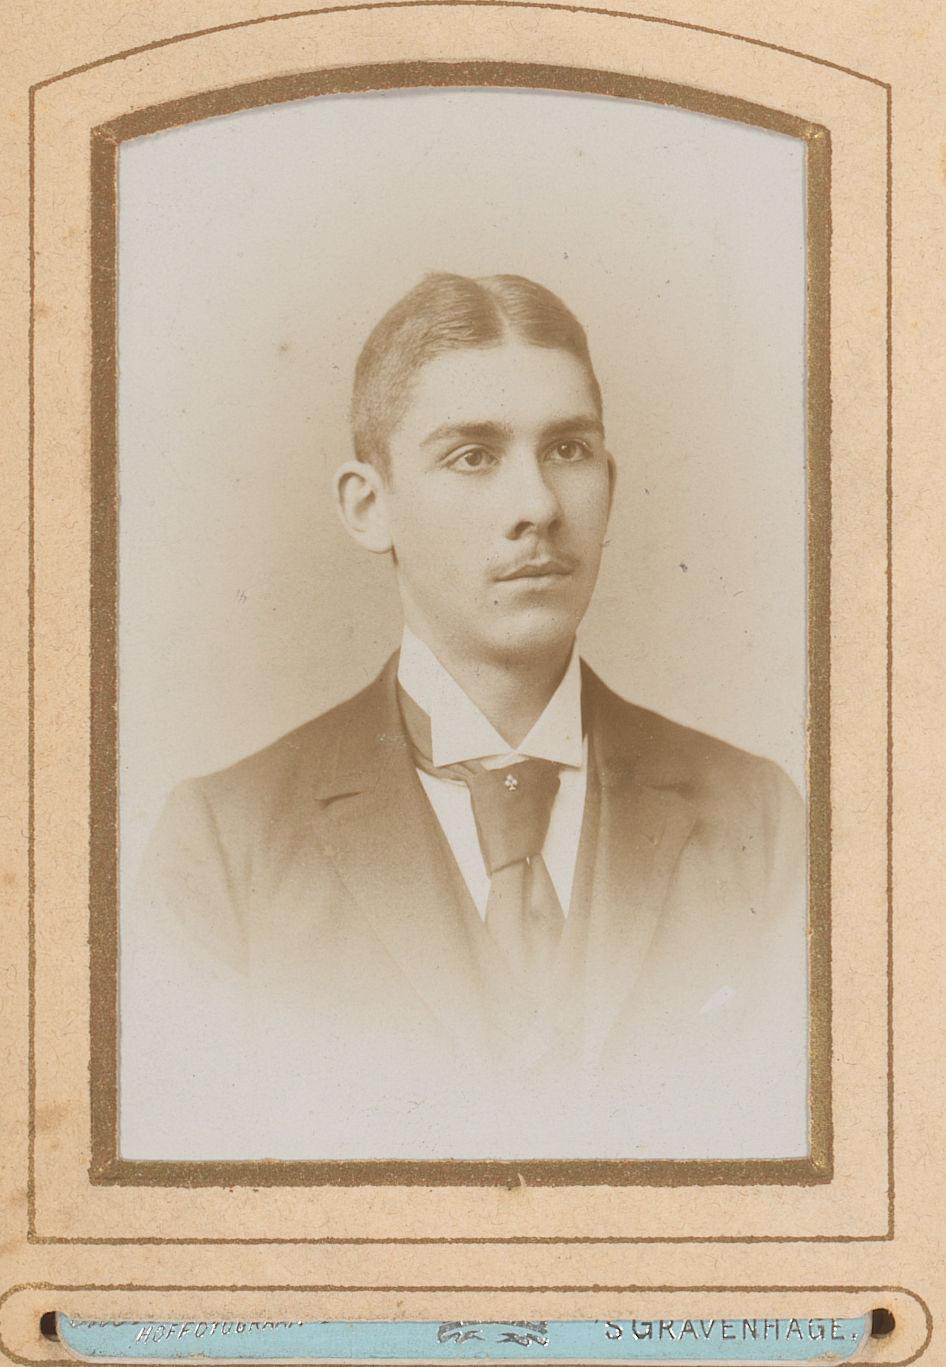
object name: photograph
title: Portret van een jongeman met snor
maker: henri de louw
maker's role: fotograaf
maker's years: 1851-1944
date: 1901-1919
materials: cardboard, photographic support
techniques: collodion silver print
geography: the hague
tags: moustache, historical persons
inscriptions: inscription: ‘Henri de Louw/ Hoffotograaf/ Prinsestraat 99/ 's Gravenhage’